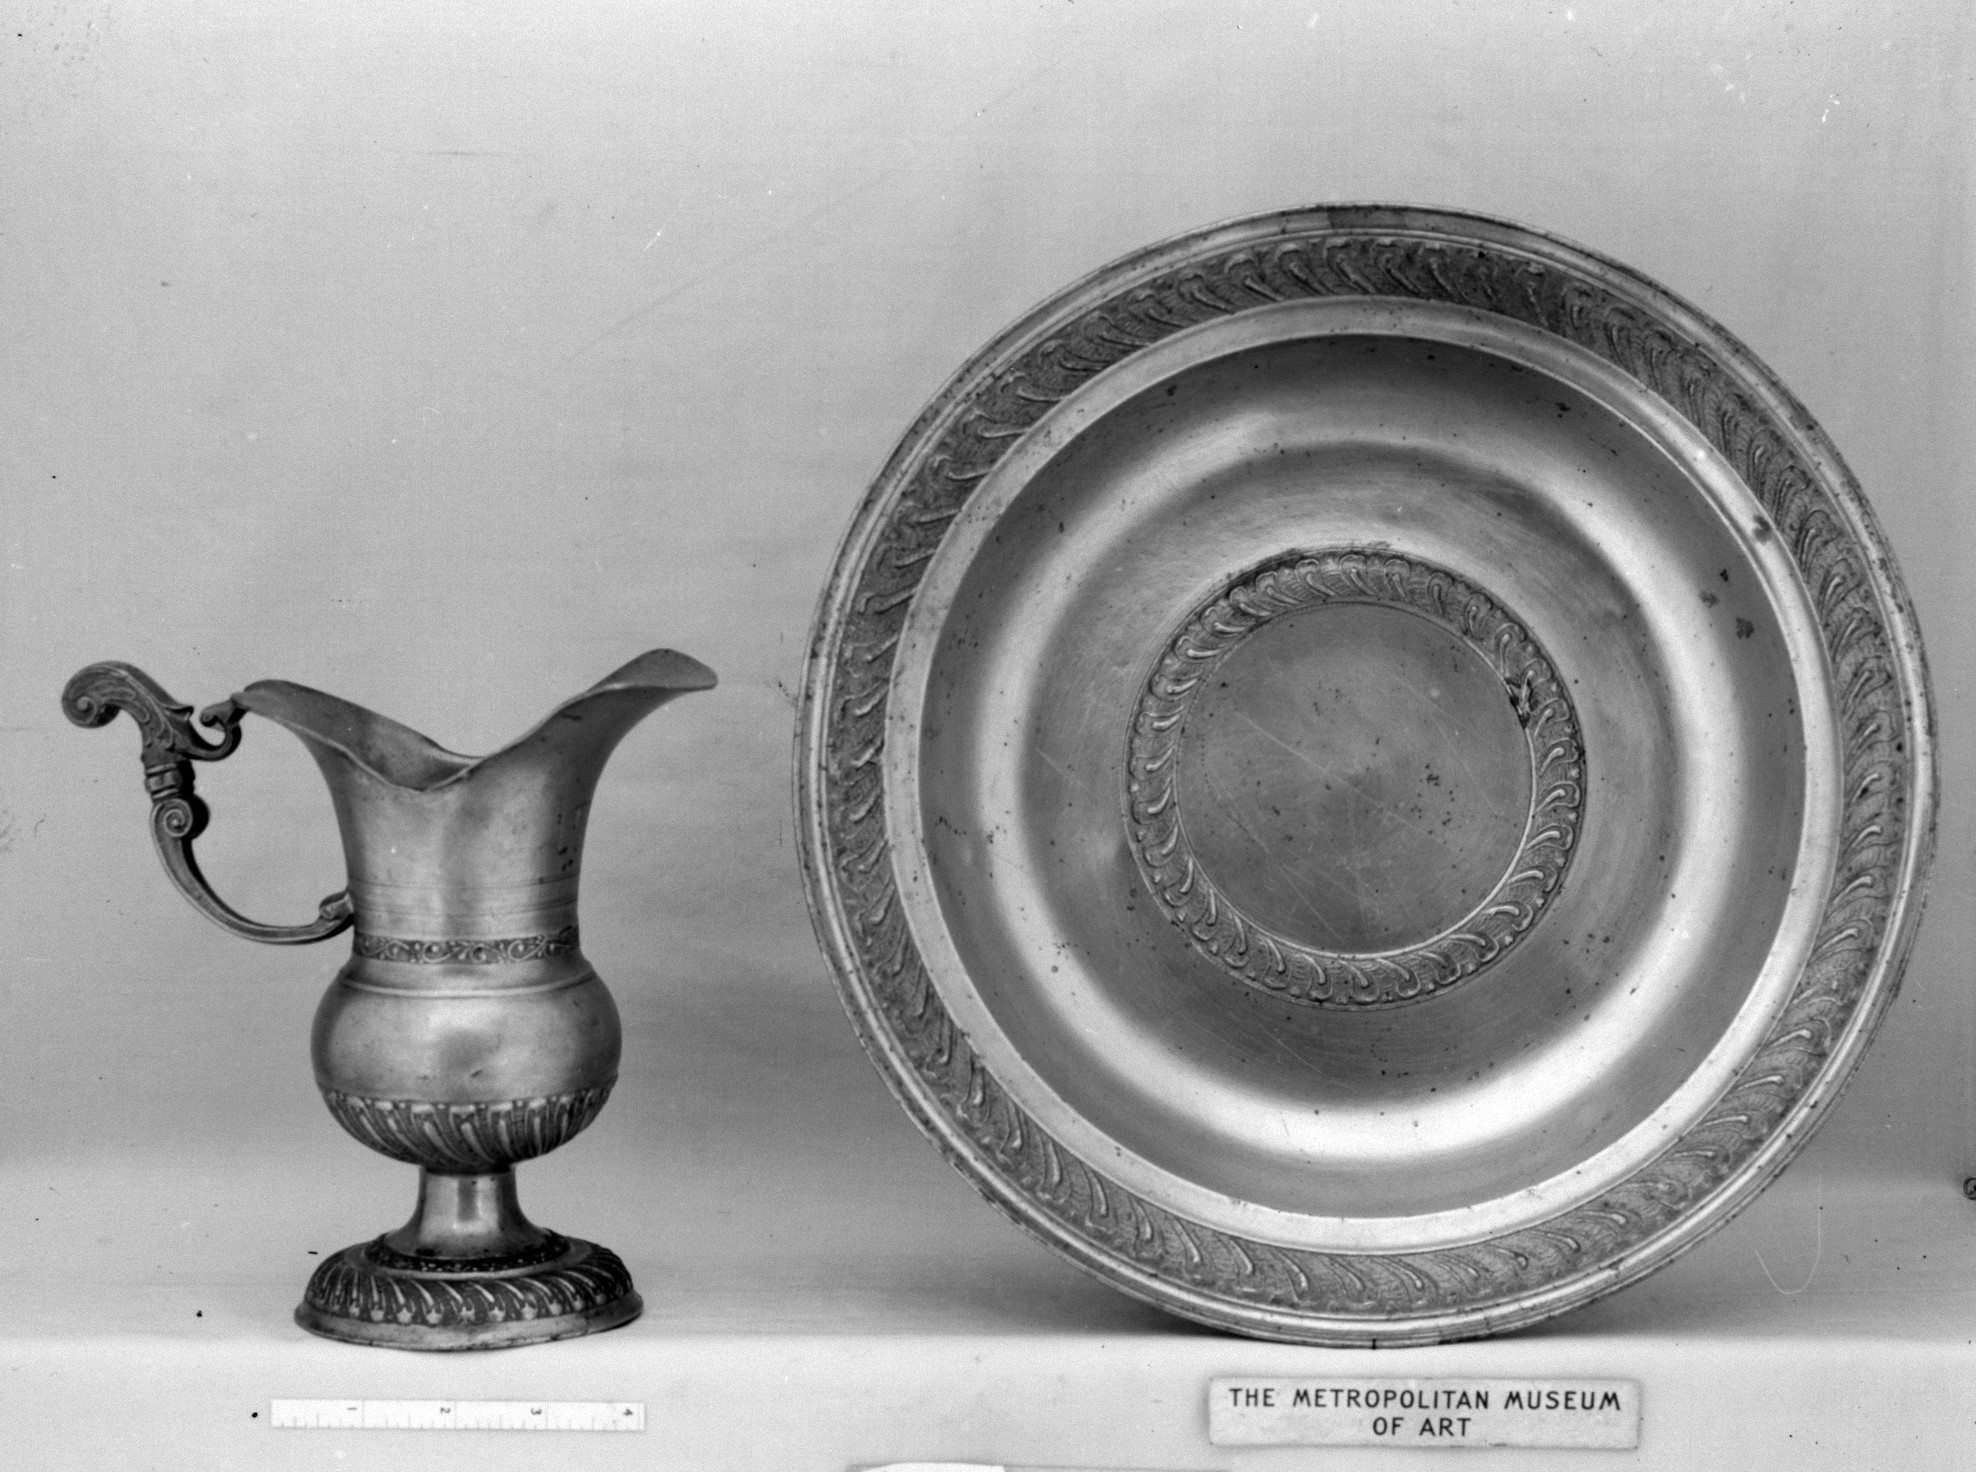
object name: ewer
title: Ewer (part of a set)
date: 1801-1900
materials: pewter